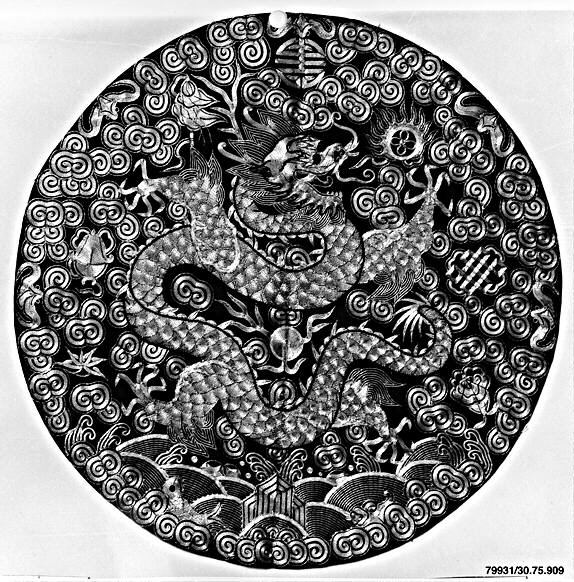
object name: medallion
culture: chinese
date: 1767-1833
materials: metal thread, silk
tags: dragons